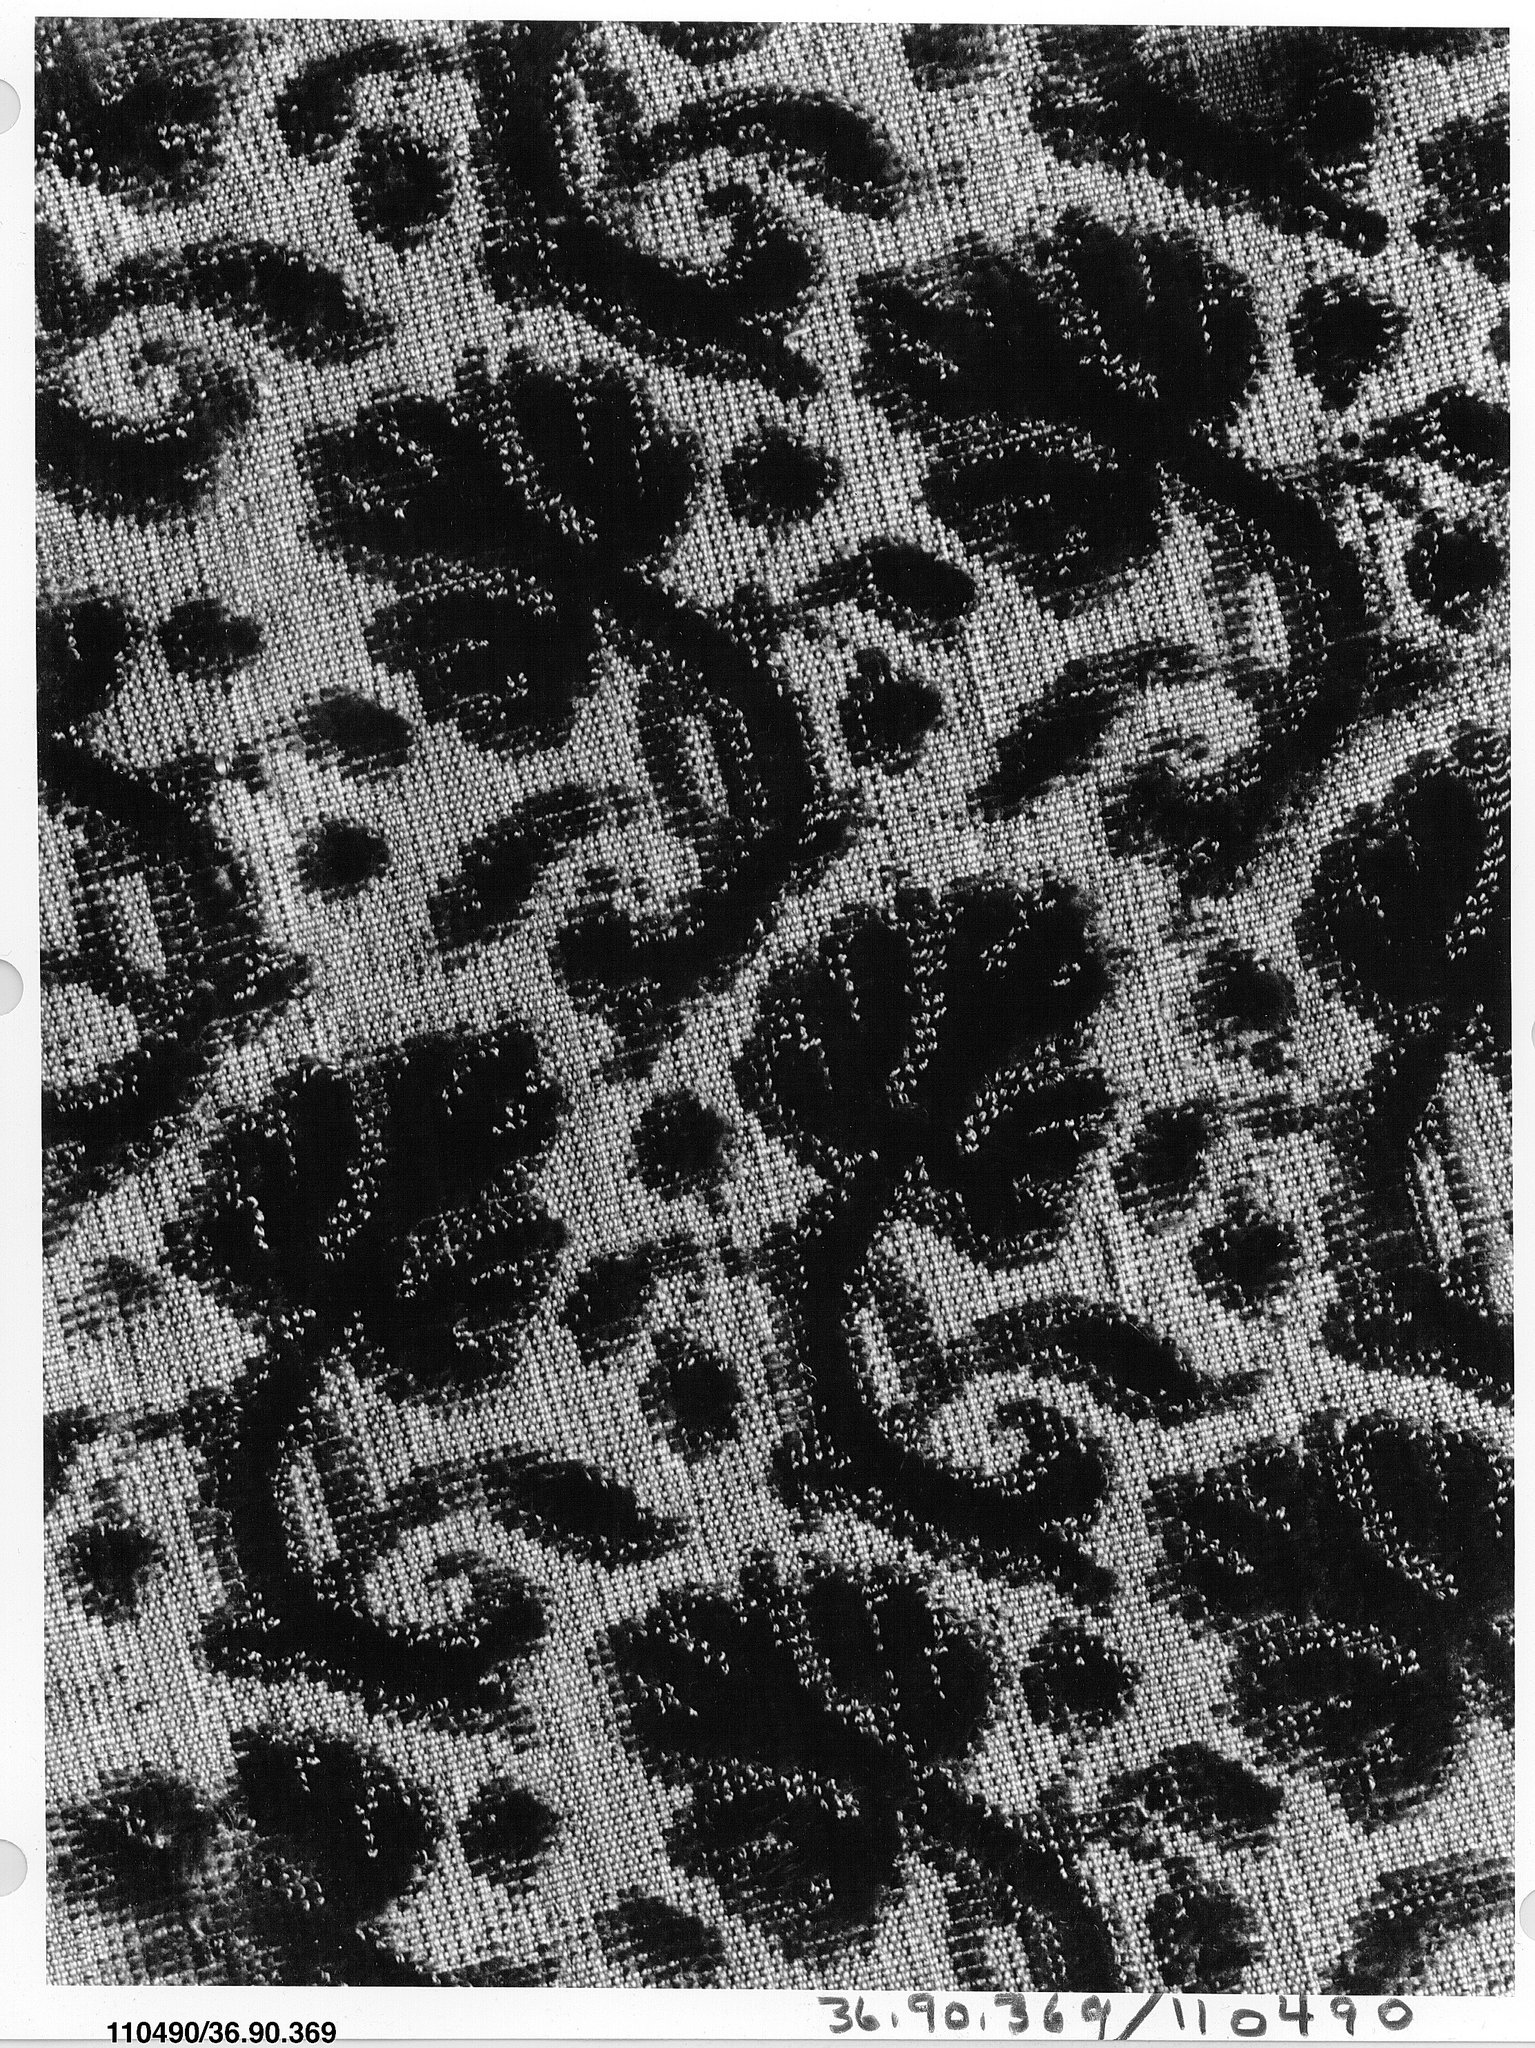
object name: piece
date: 1501-1700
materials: silk